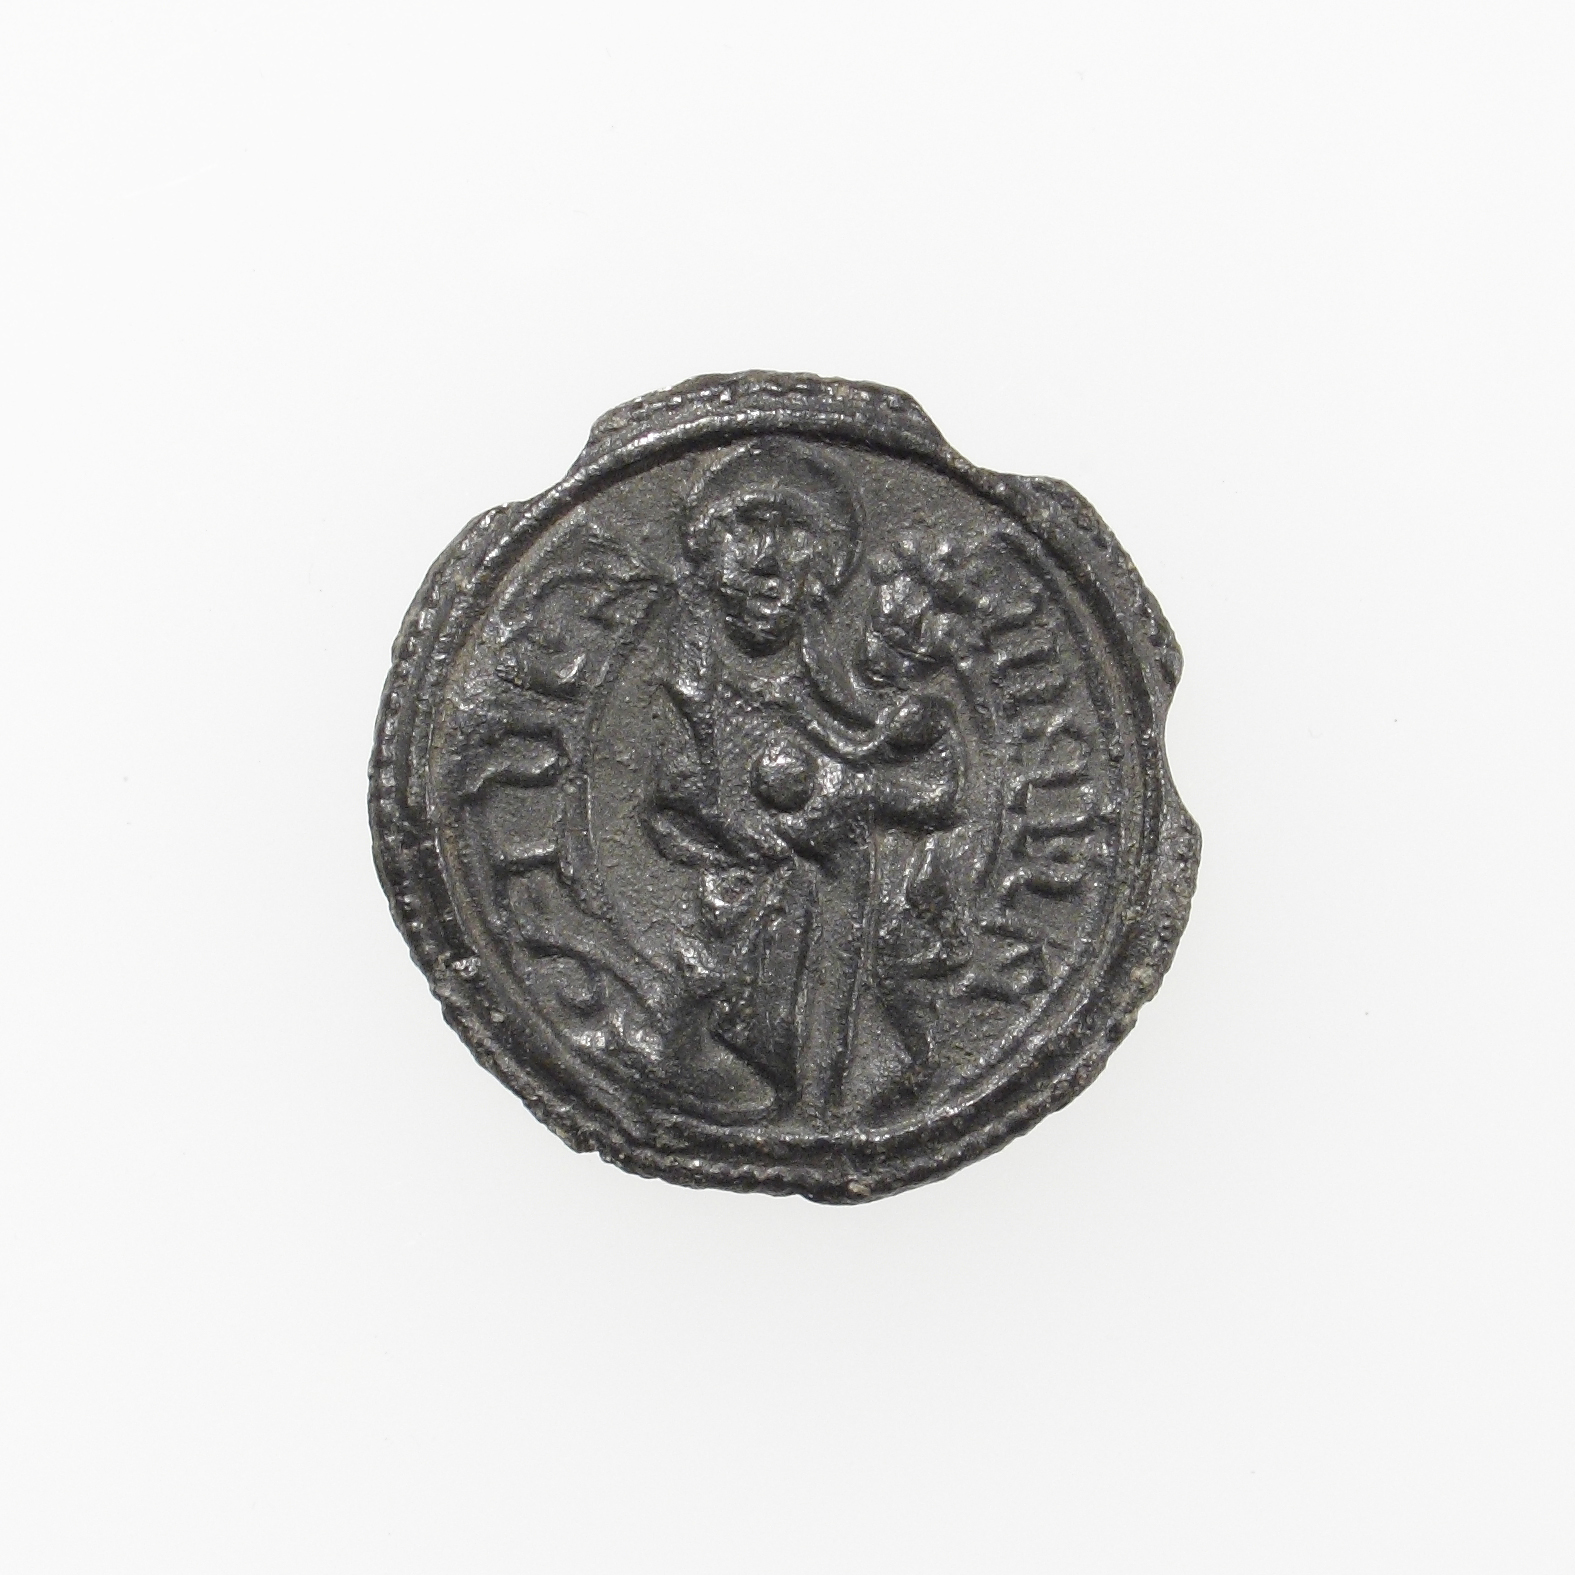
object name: pilgrim's badge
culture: french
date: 1301-1600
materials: lead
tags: madonna and child